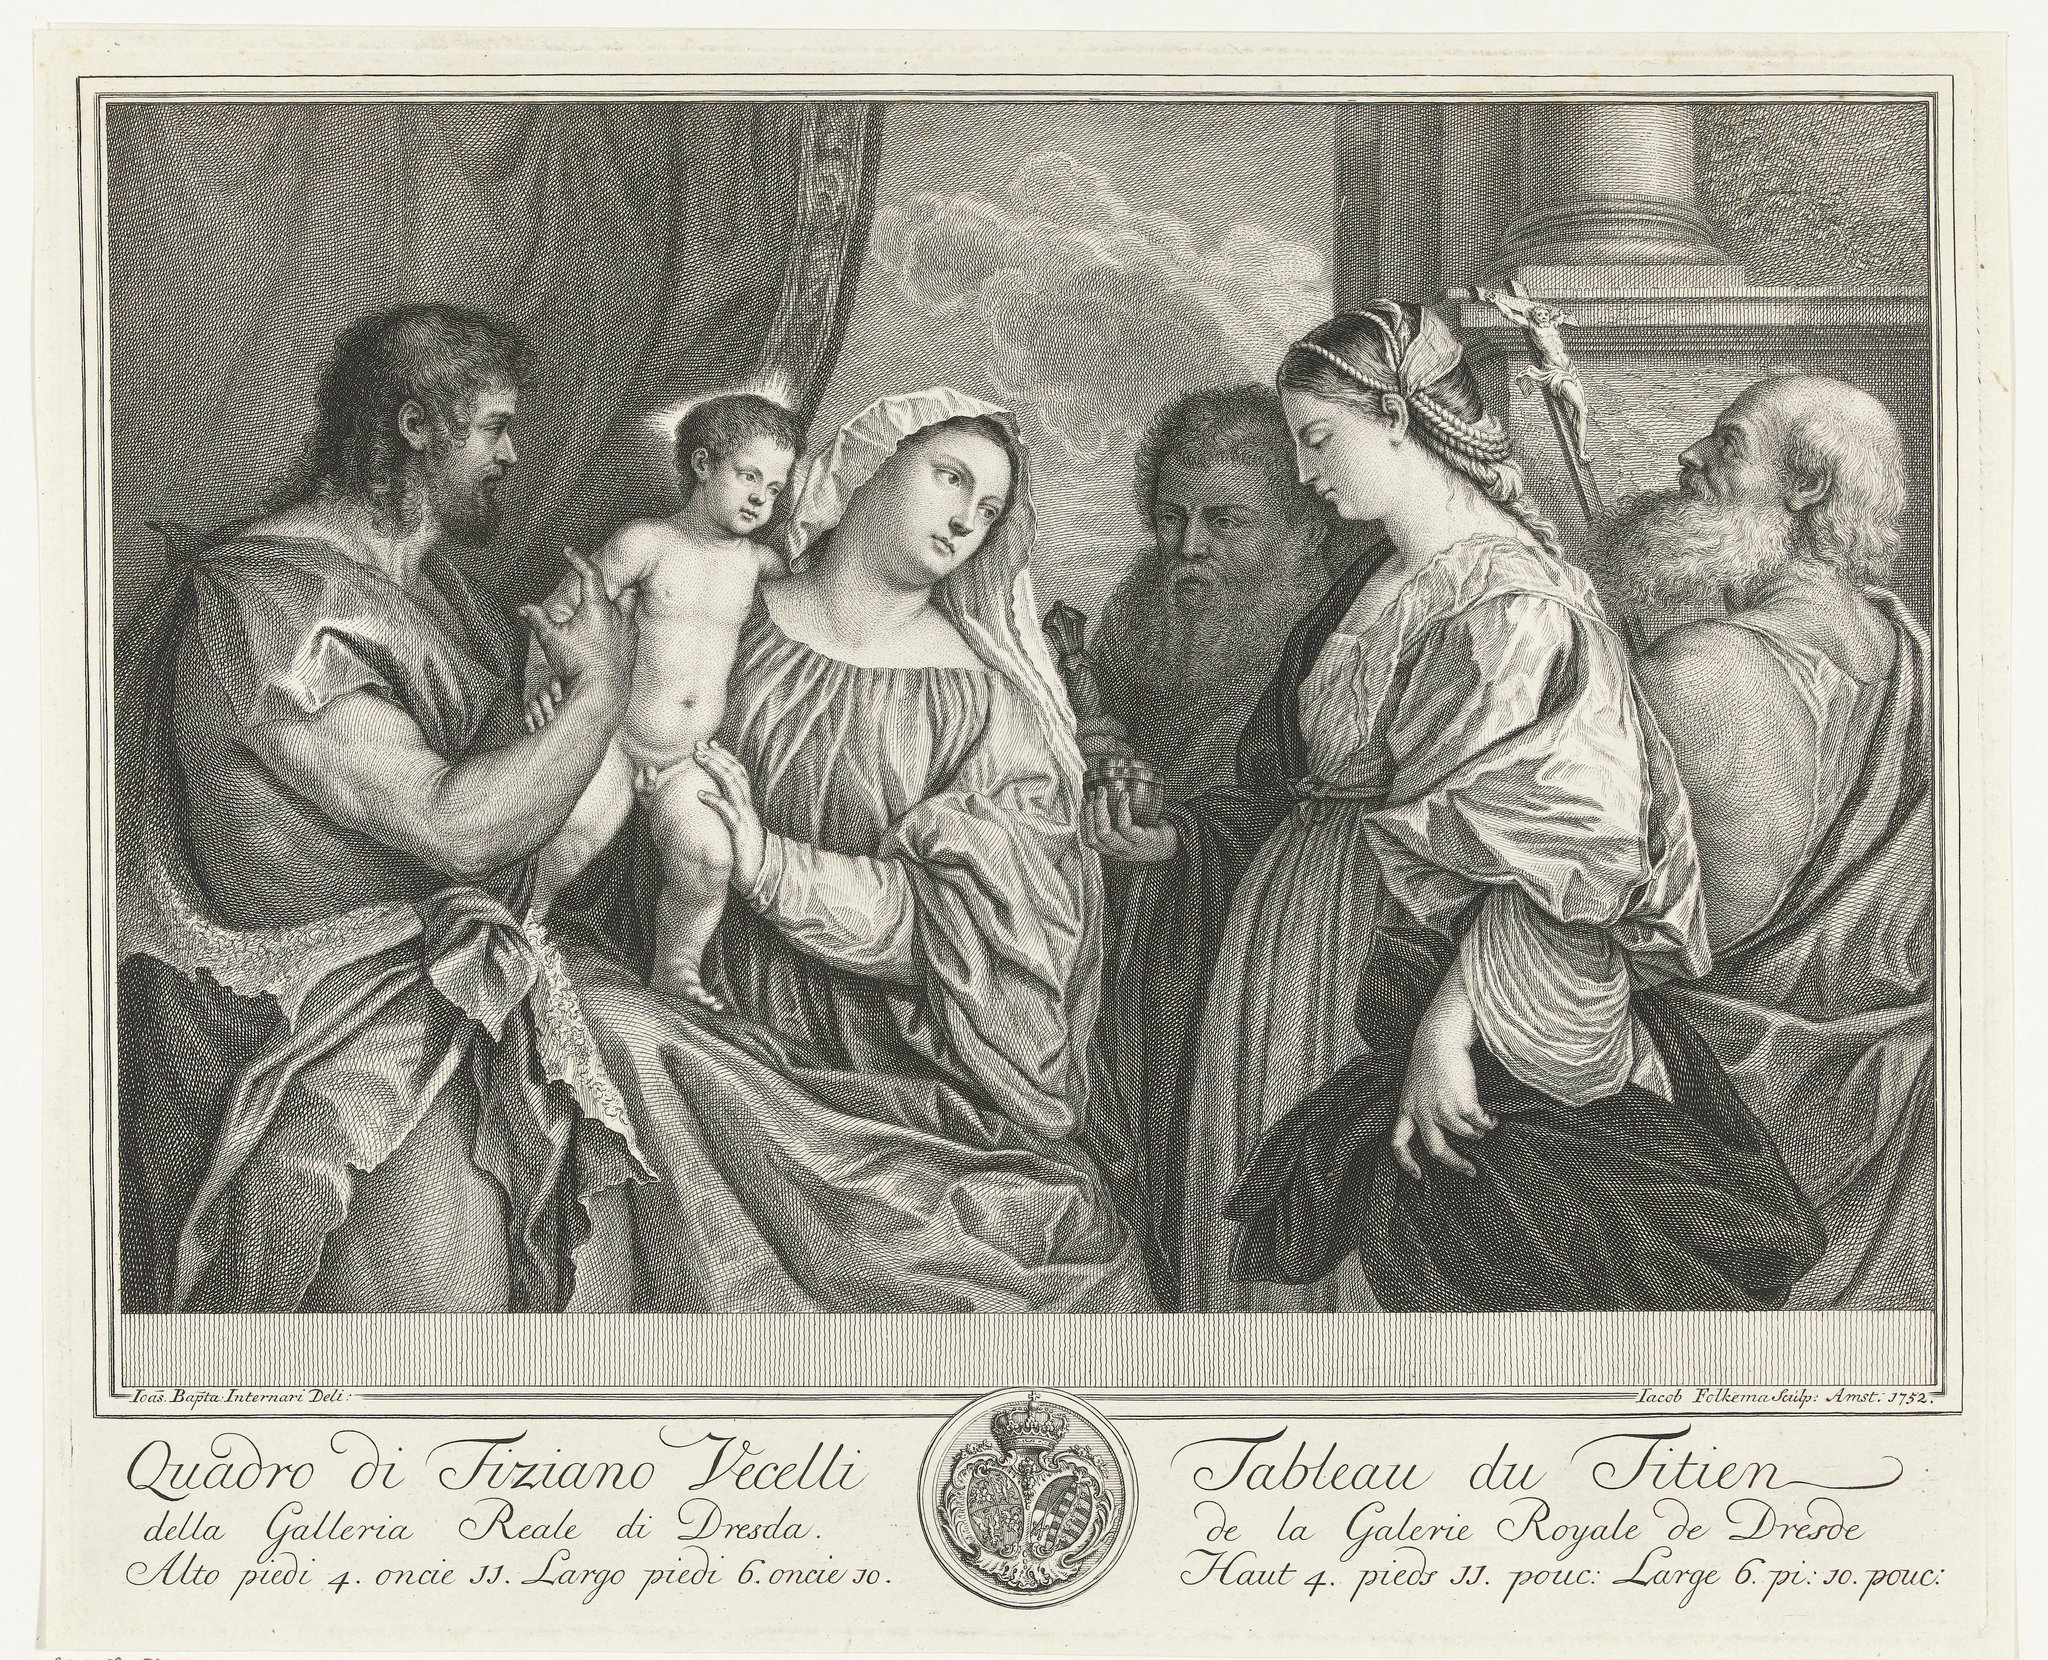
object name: print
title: Maria en kind met heiligen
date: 1752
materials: paper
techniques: etching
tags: john the baptist; possible attributes: book, reed cross, baptismal cup, honeycomb, lamb, staff, madonna accompanied by saint(s), the monk and hermit jerome (hieronymus); possible attributes: book, cardinal's hat, crucifix, hour-glass, lion, skull, stone, the penitent harlot mary magdalene; possible attributes: book (or scroll), crown, crown of thorns, crucifix, jar of ointment, mirror, musical instrument, palm-branch, rosary, scourge, the apostle paul of tarsus; possible attributes: book, scroll, sword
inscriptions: date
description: Maria en kind worden omringd door links Johannes de Doper en rechts Paulus, Maria Magdalena en Hieronymus. In de marge onder de voorstelling staan twee wapenschilden in een cartouche, met links een tekst in het Italiaans en rechts een tekst in het Frans.